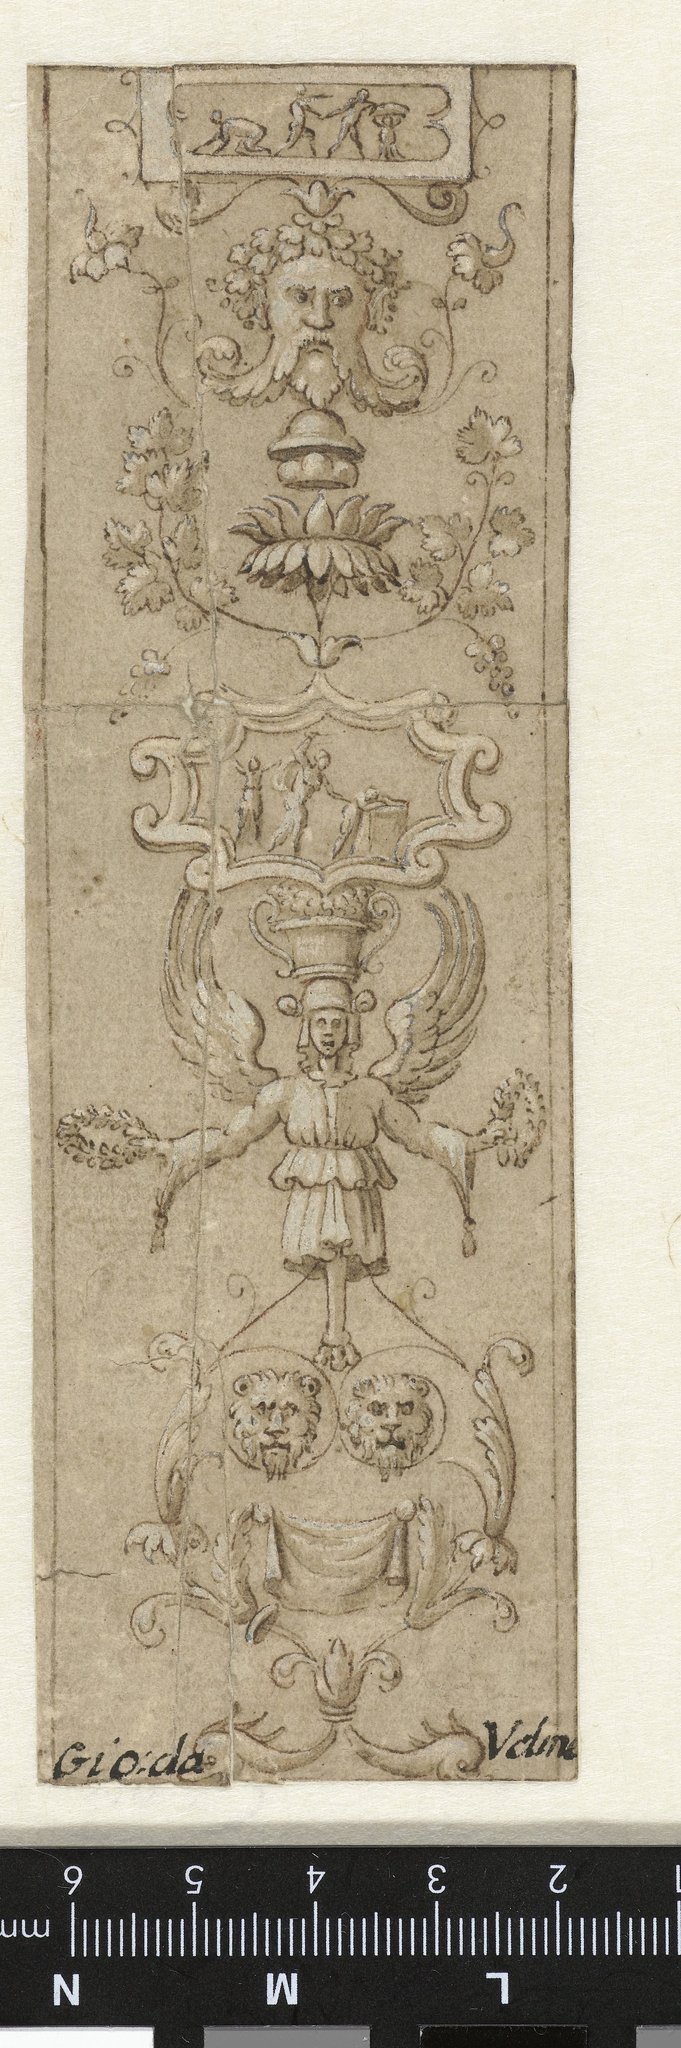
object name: drawing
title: Decoratieve paneelvulling uit de Loggiën van het Vaticaan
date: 1510-1600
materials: ink, paper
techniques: brush, pen